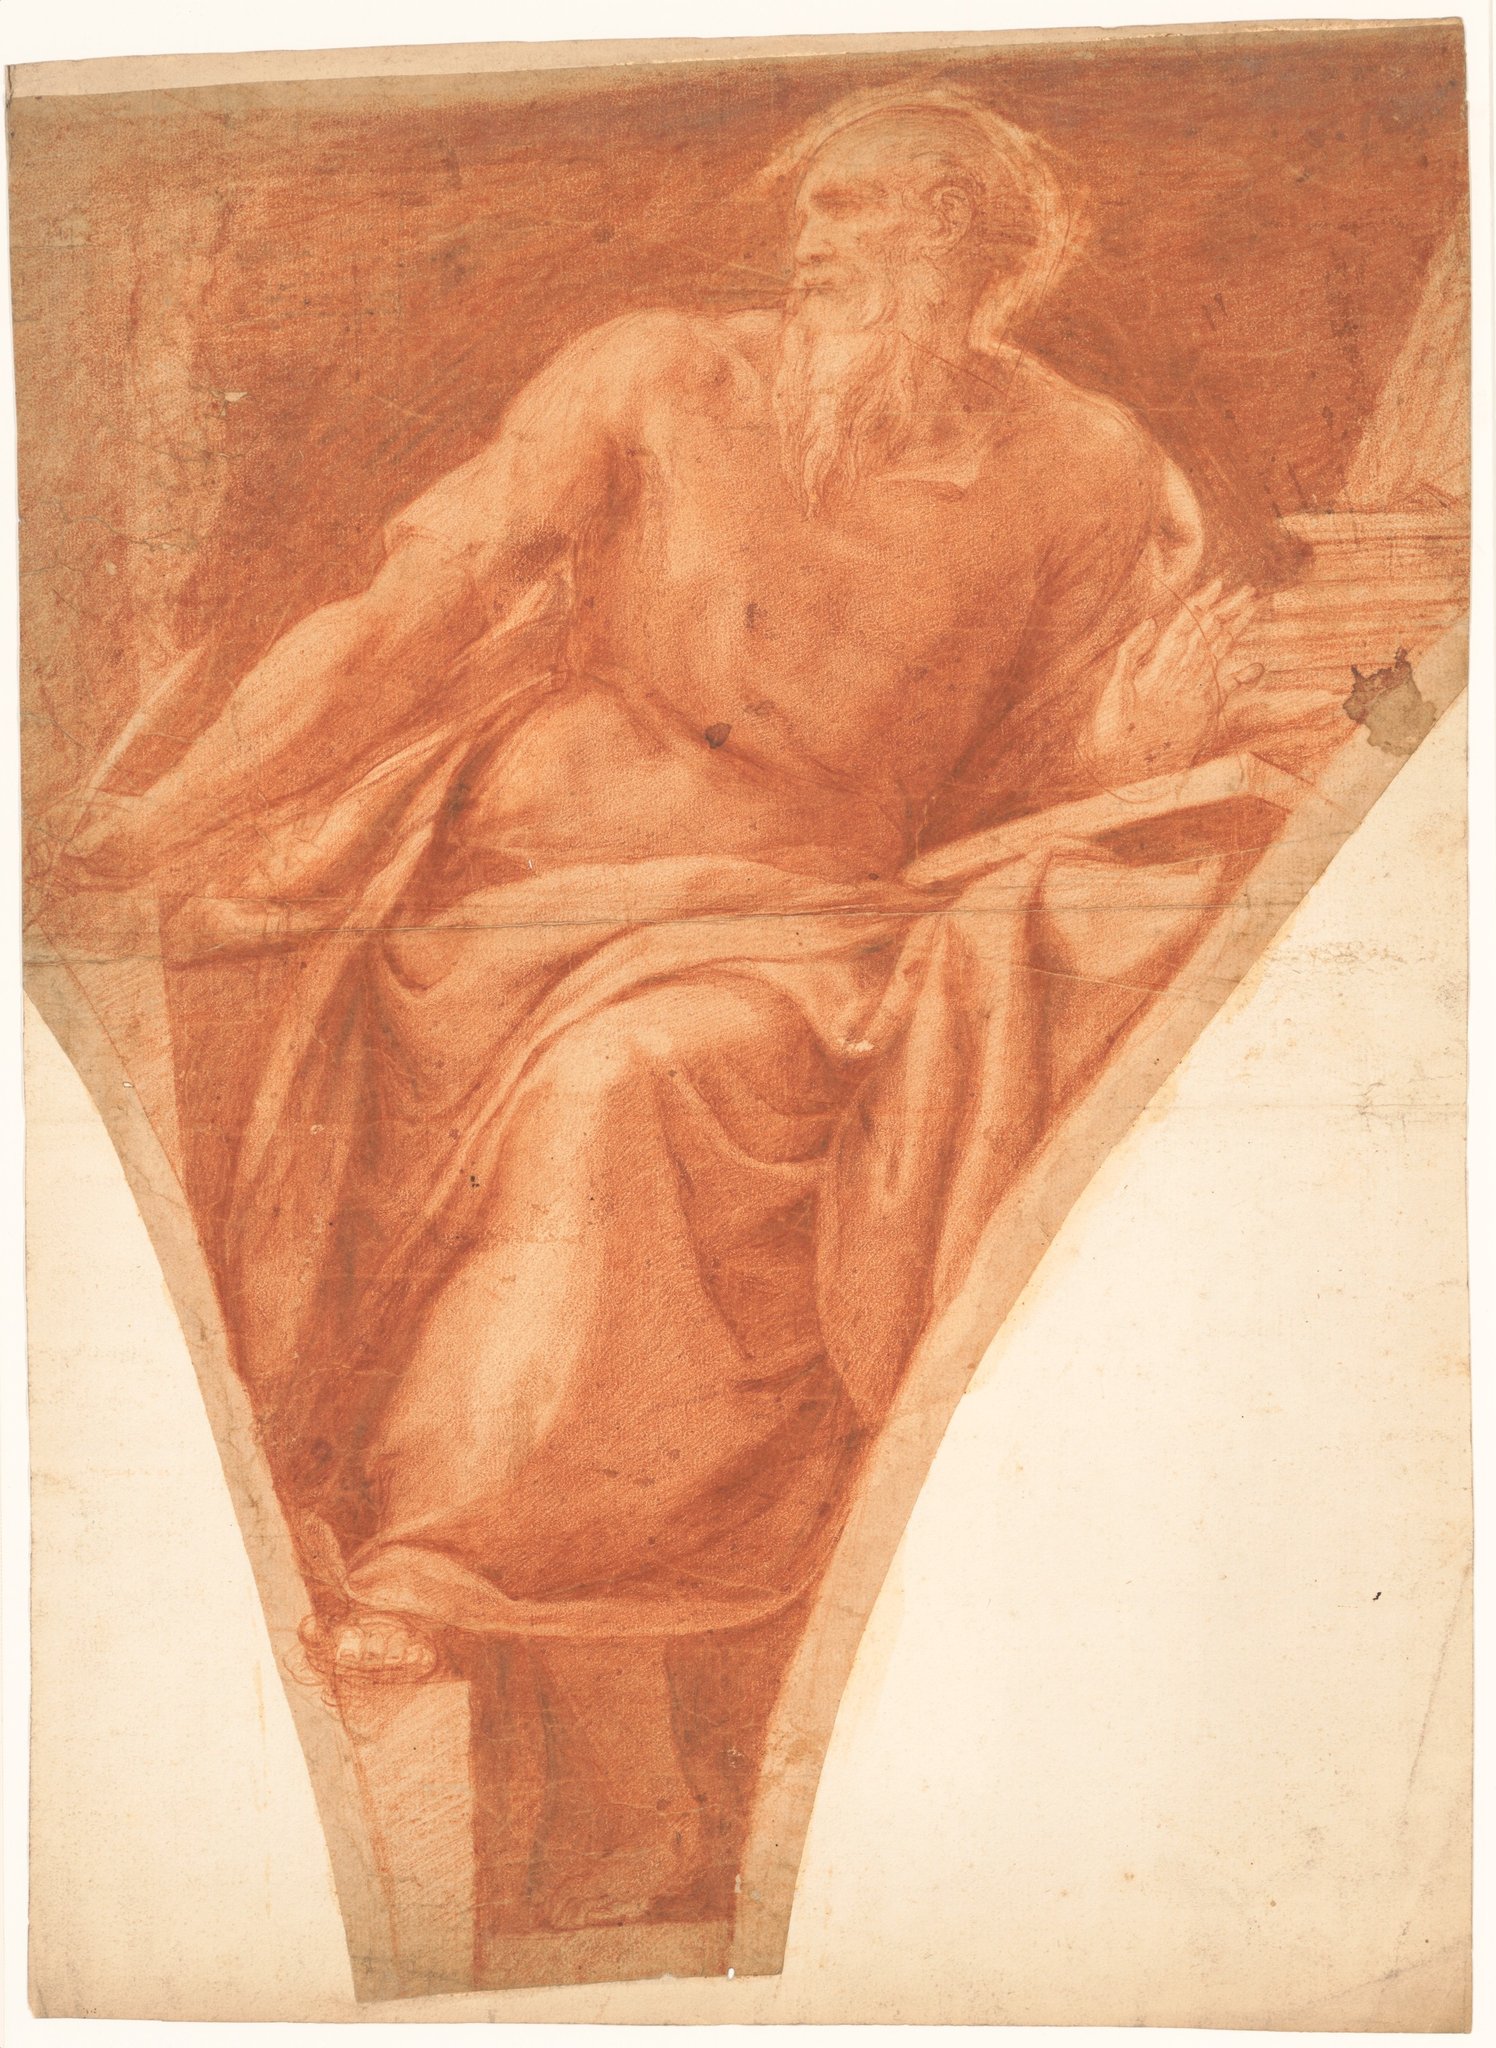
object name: drawing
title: Study of St. Jerome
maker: girolamo muziano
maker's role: artist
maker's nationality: italian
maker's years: 1528-1592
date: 1578-1579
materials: chalk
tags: men